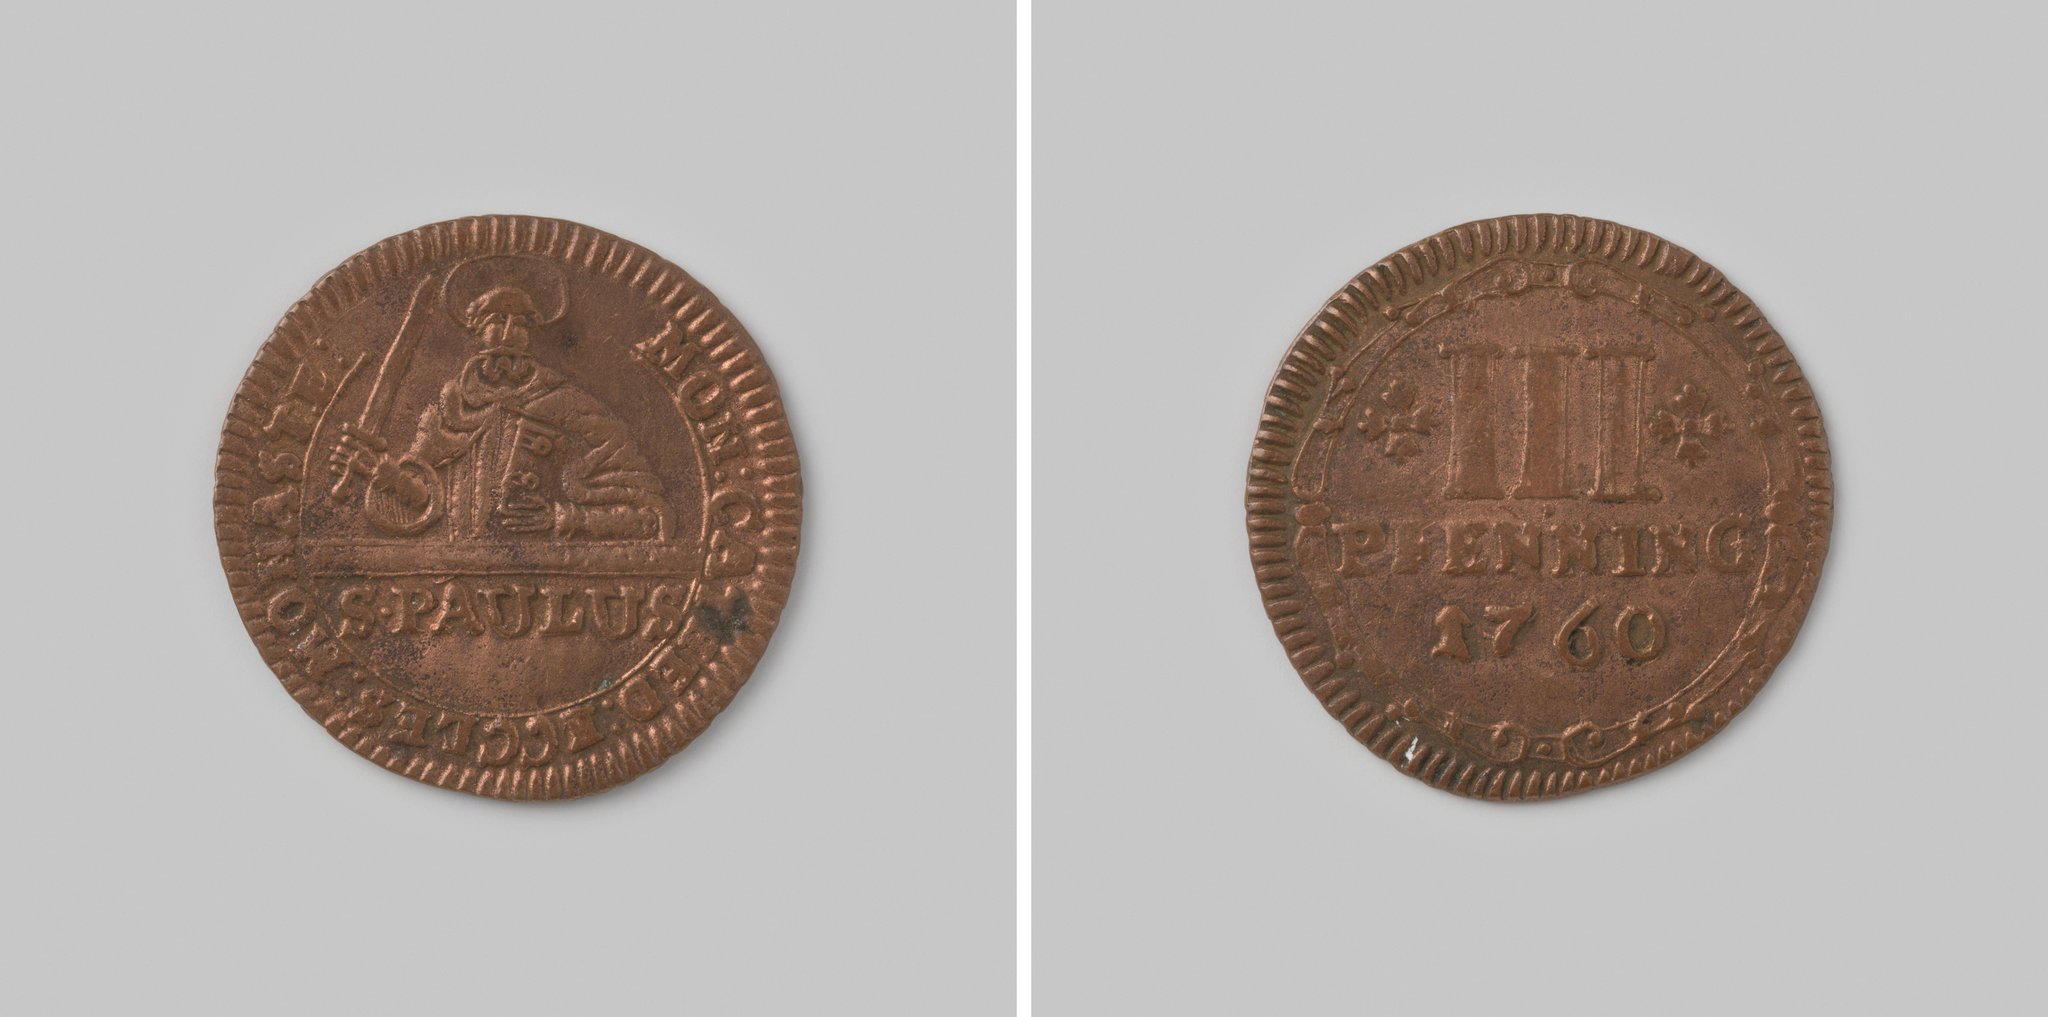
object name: drie pfenning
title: Domkapittel van Münster, drie pfenning,1760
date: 1760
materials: copper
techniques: striking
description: Koperen munt. Voorzijde: de heilige Paulus met boek en zwaard, zittend aan een tafel. Daaronder zijn naam. Keerzijde: binnen een cirkelvomige versiering waarde-aanduiding in twee regels, waaronder jaartal. Kabelrand.